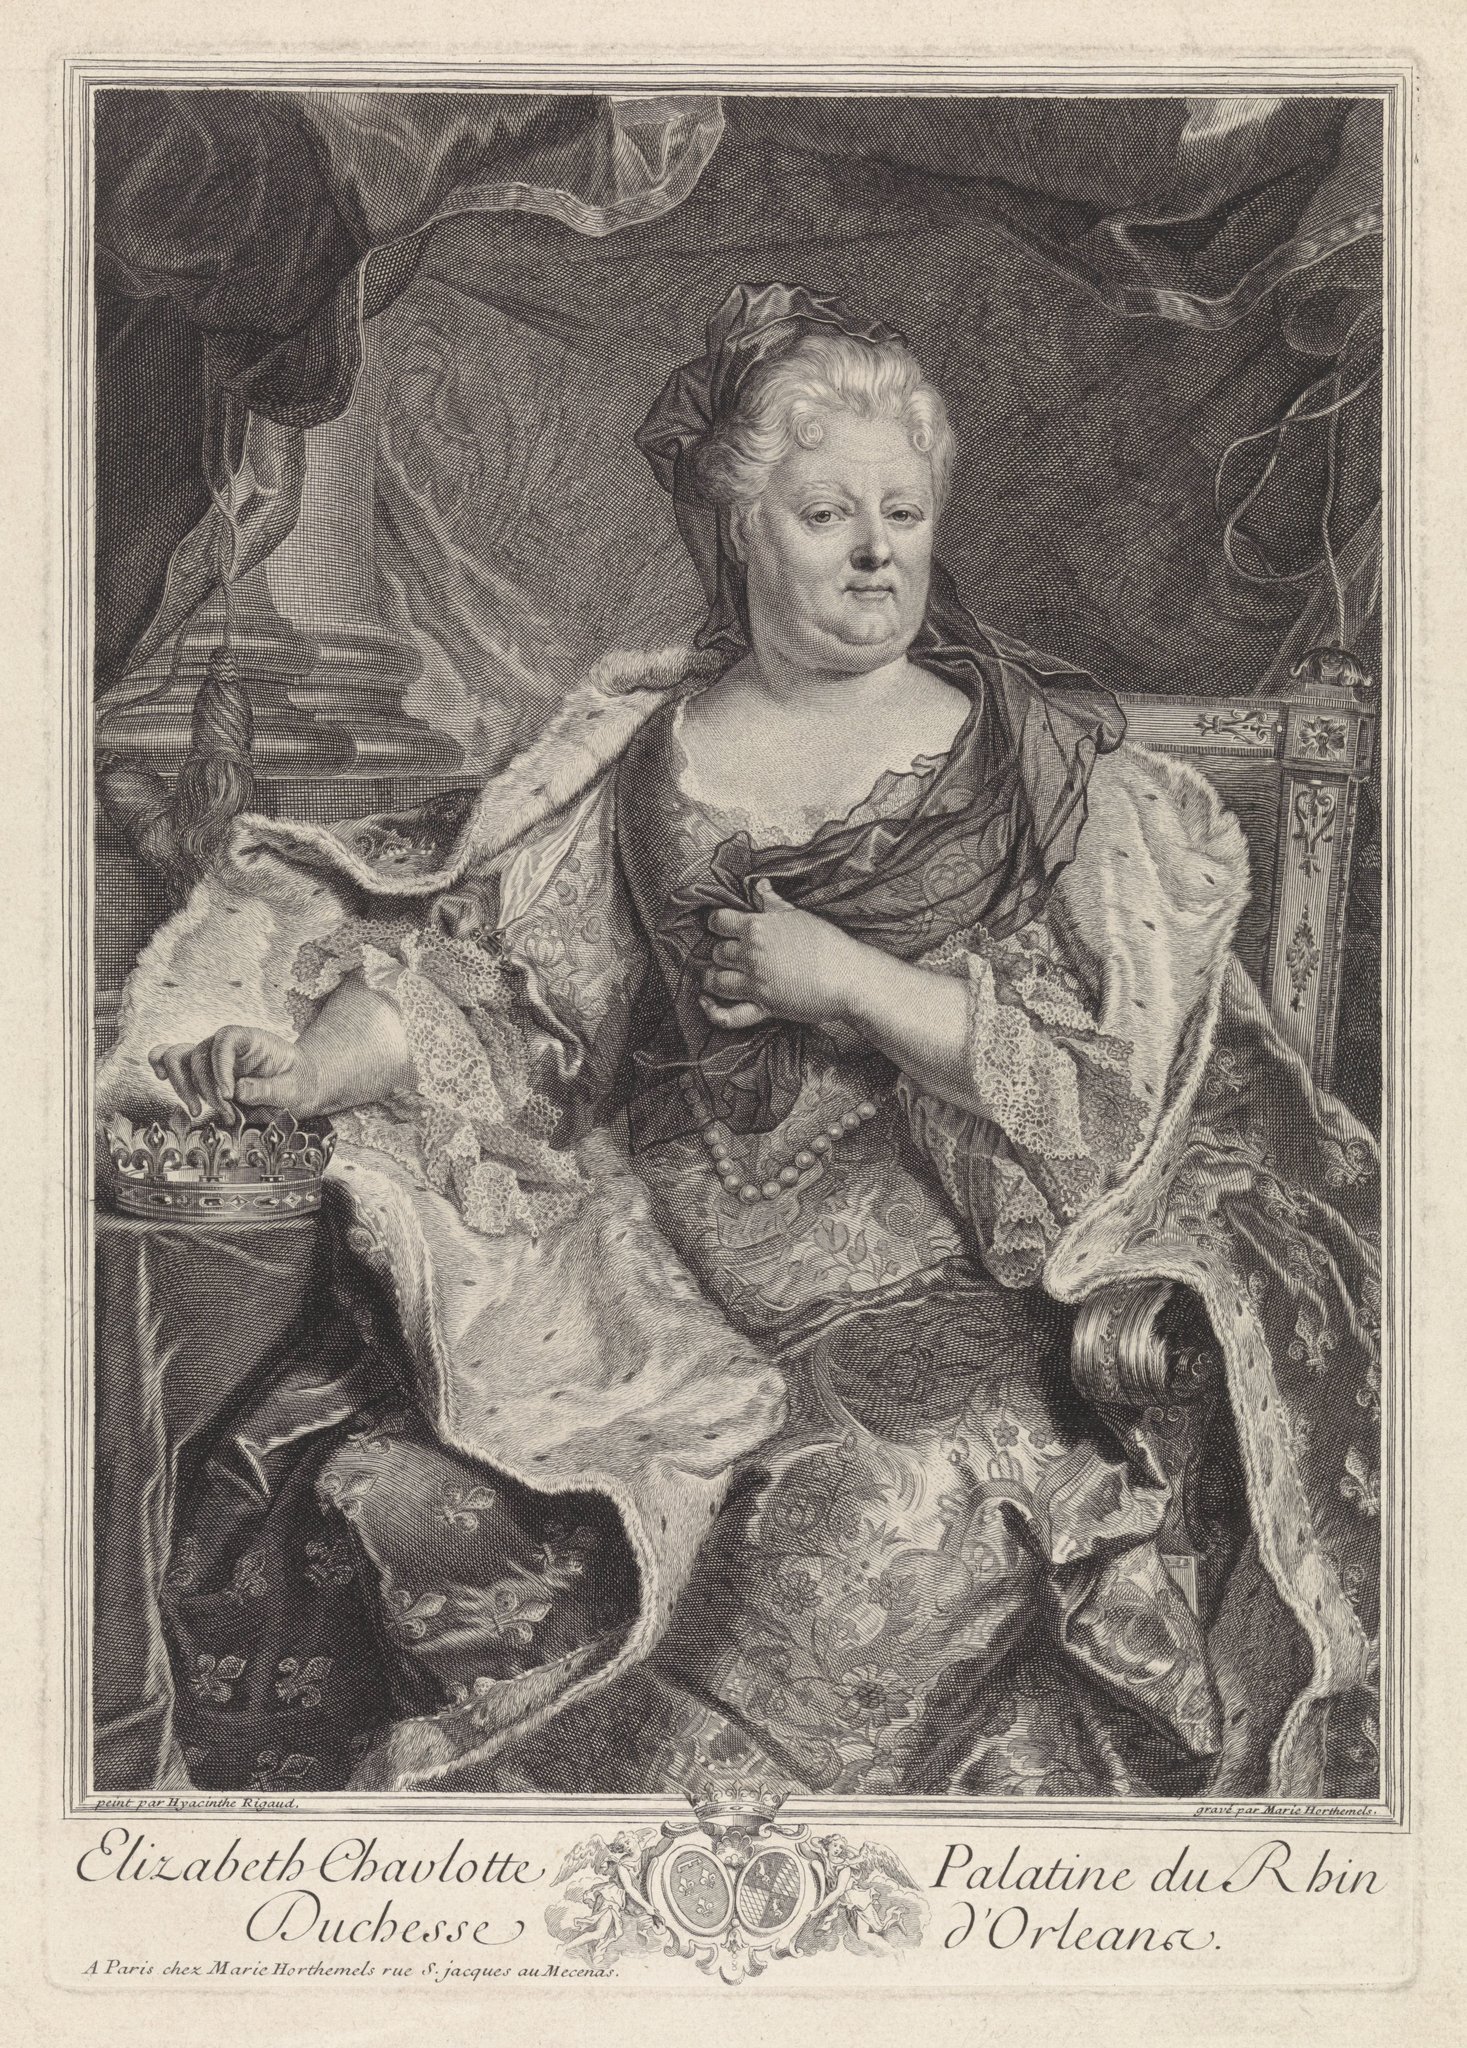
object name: print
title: Portret van Elisabeth Charlotte van de Palts, hertogin van Orleans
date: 1700-1767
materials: paper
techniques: engraving, etching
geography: paris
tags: crown (symbol of sovereignty), royal mantle (symbol of sovereignty)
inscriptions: collector's mark: Lugt 2228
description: Portret van Elisabeth Charlotte van de Palts, hertogin van Orleans, gekleed in een koningsmantel, haar hand rustend op een kroon.